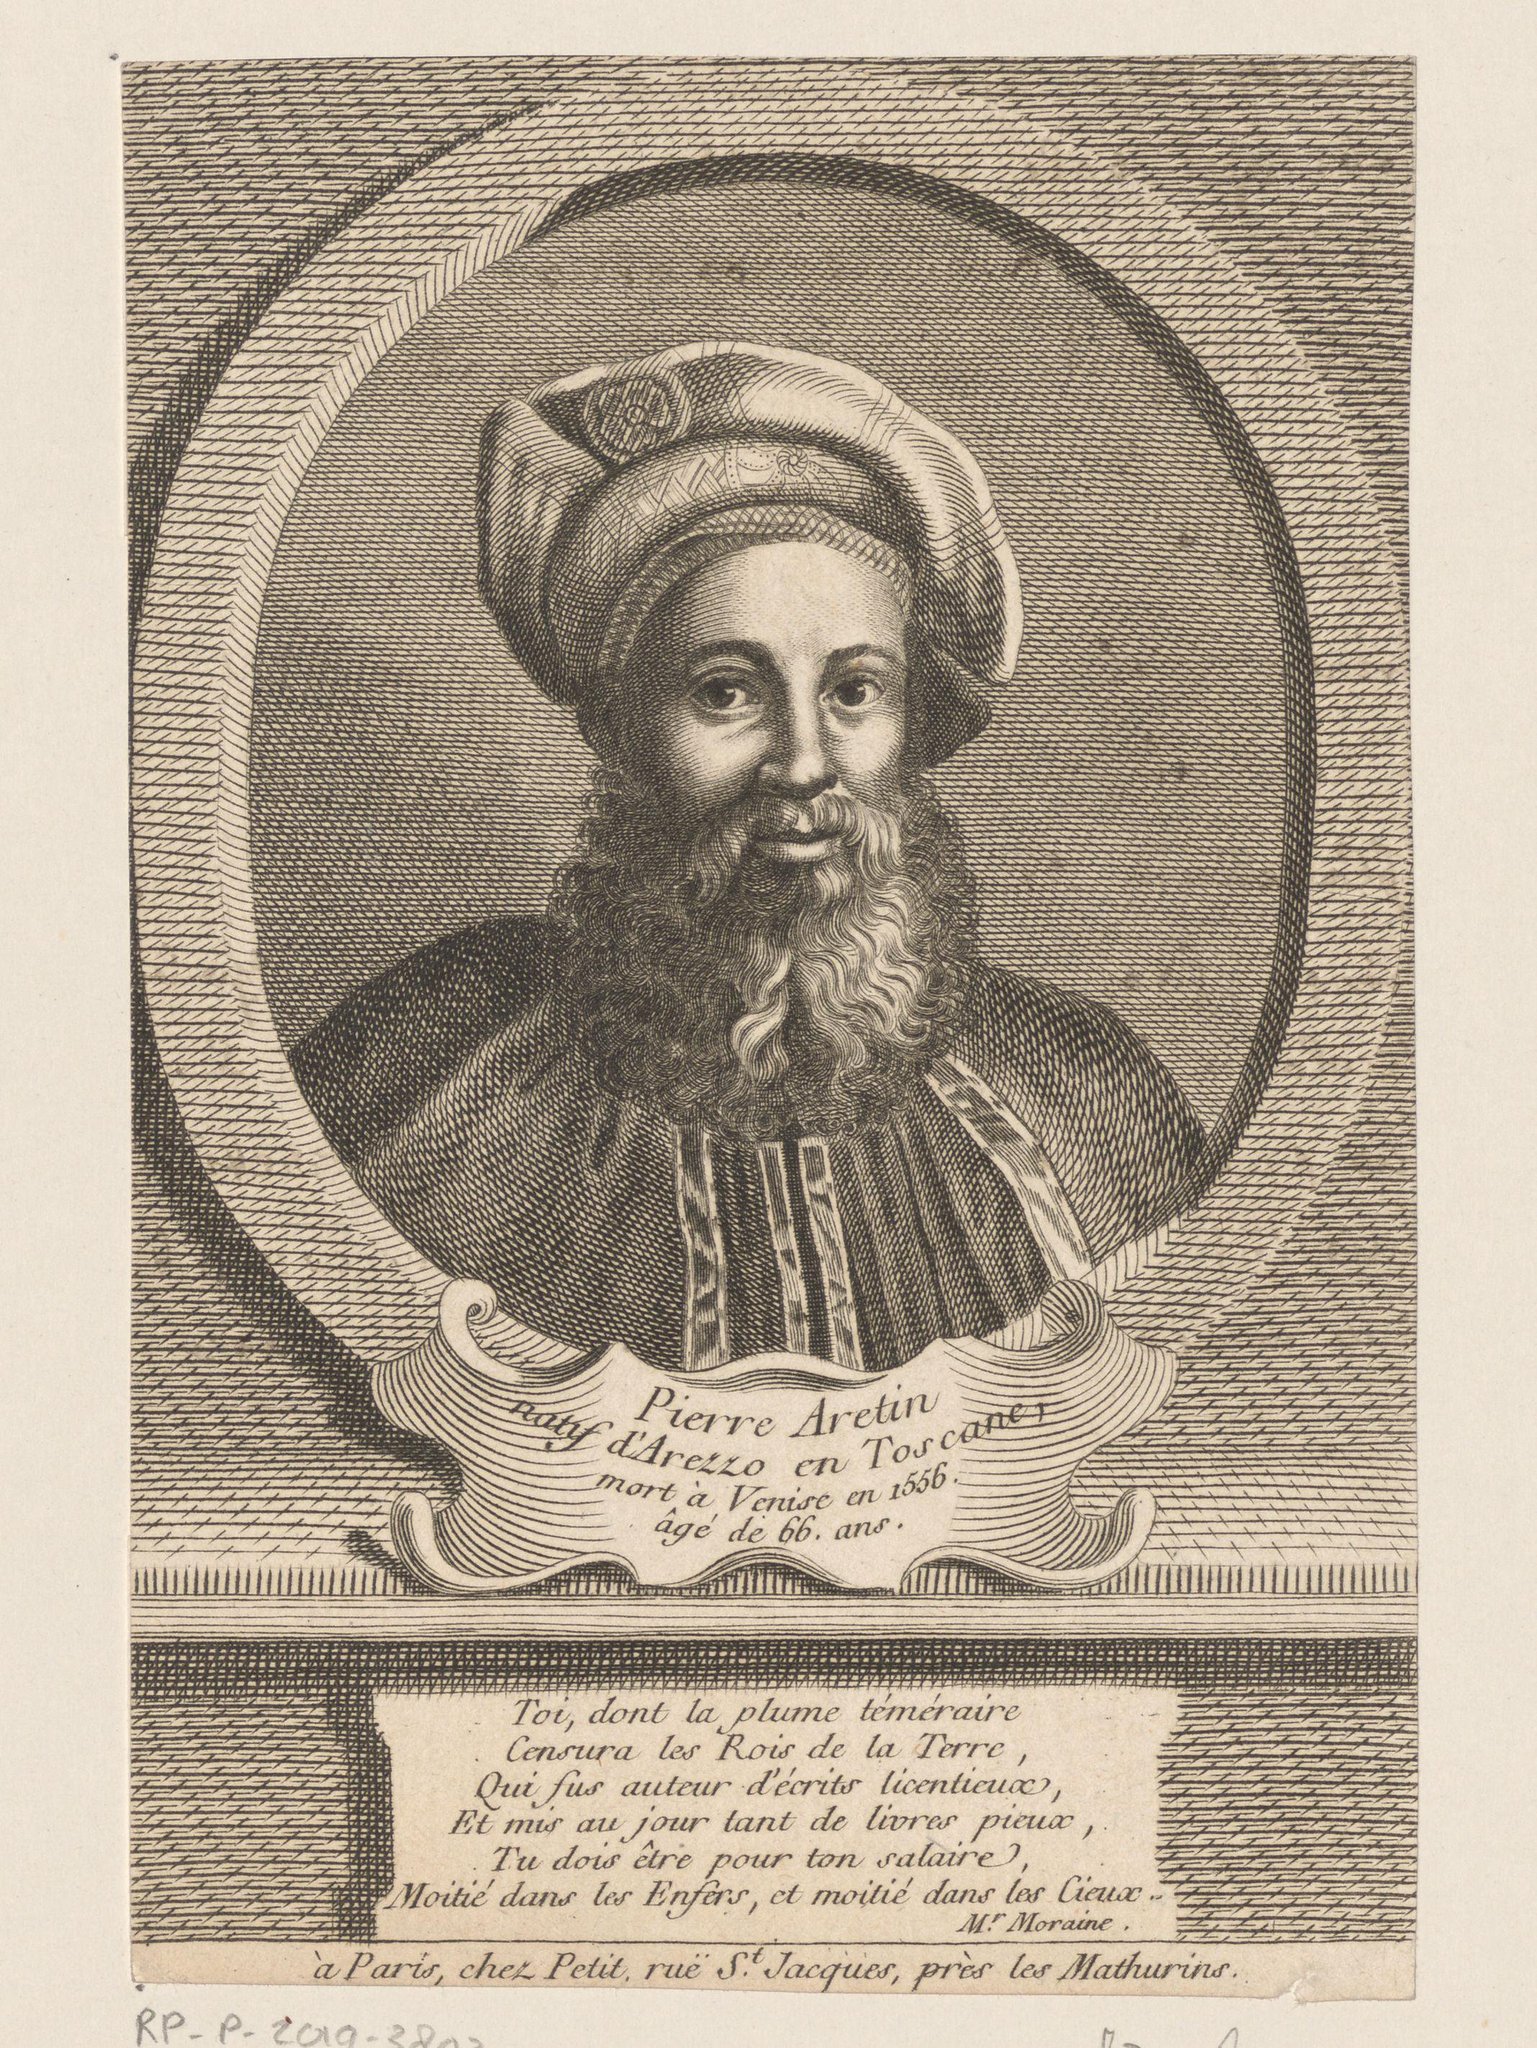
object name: print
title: Portret van Pietro Aretino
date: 1729-1742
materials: paper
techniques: engraving, etching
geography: paris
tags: venice, historical persons